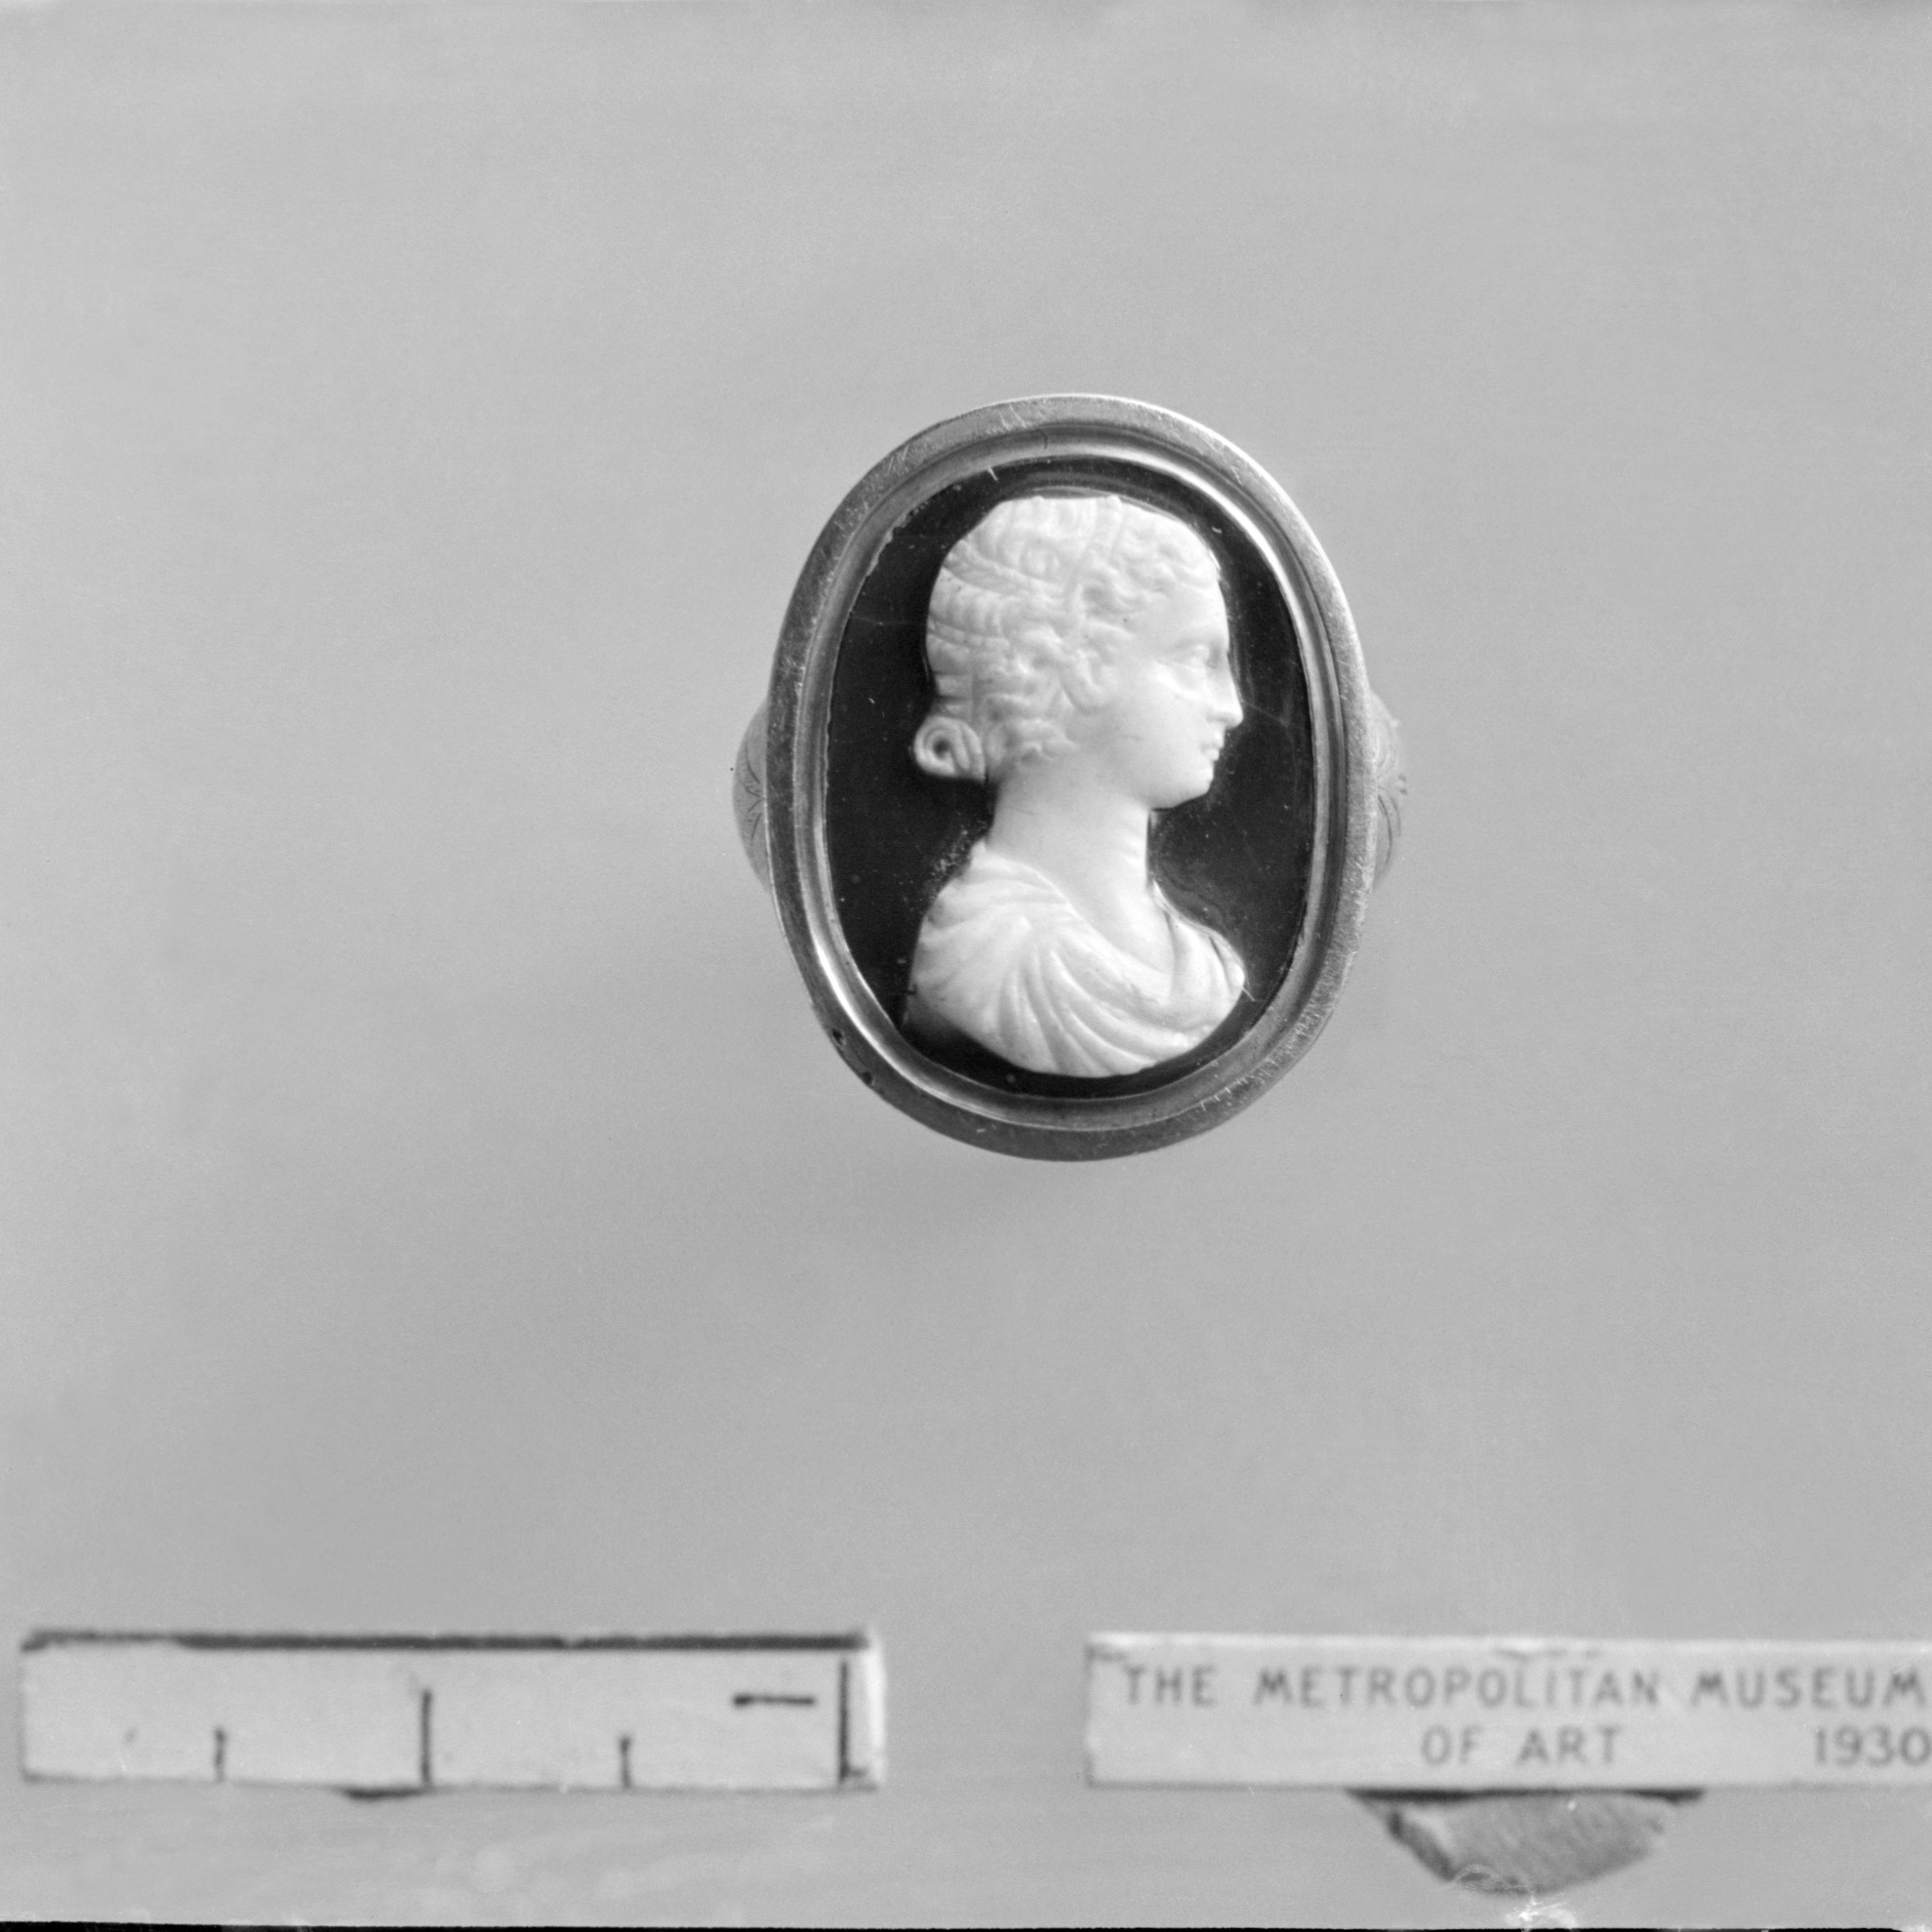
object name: cameo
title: Head of a maiden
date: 1601-1800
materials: gold, onyx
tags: heads,profiles,women